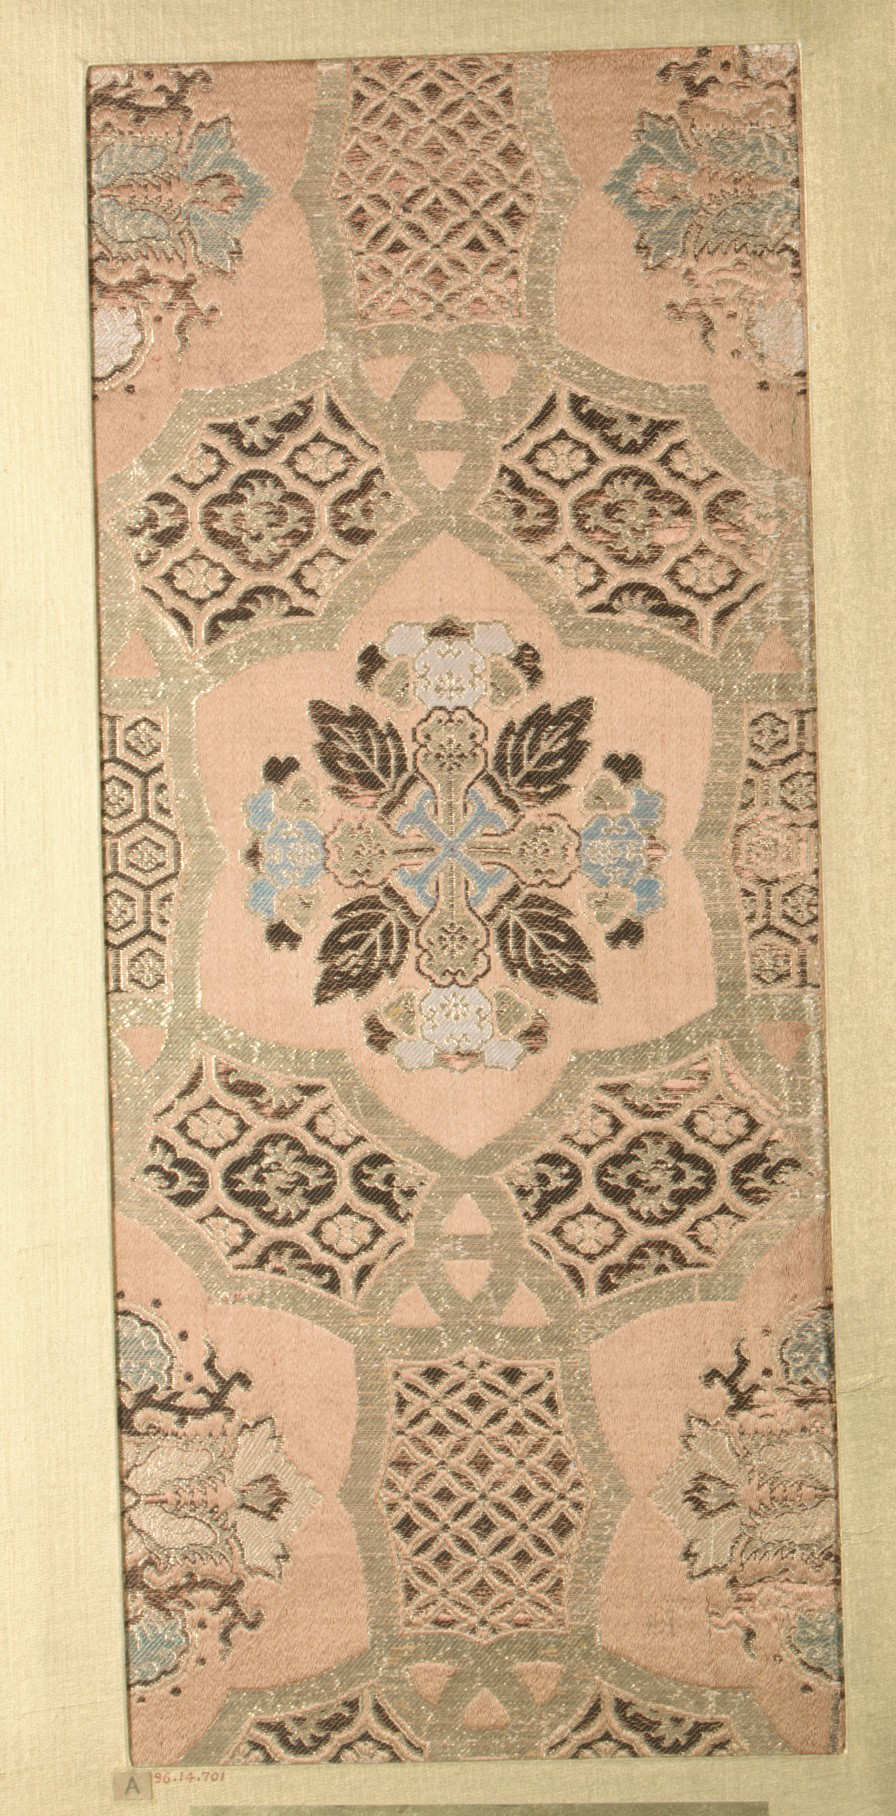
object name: piece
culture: japanese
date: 1701-1900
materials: silk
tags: leaves